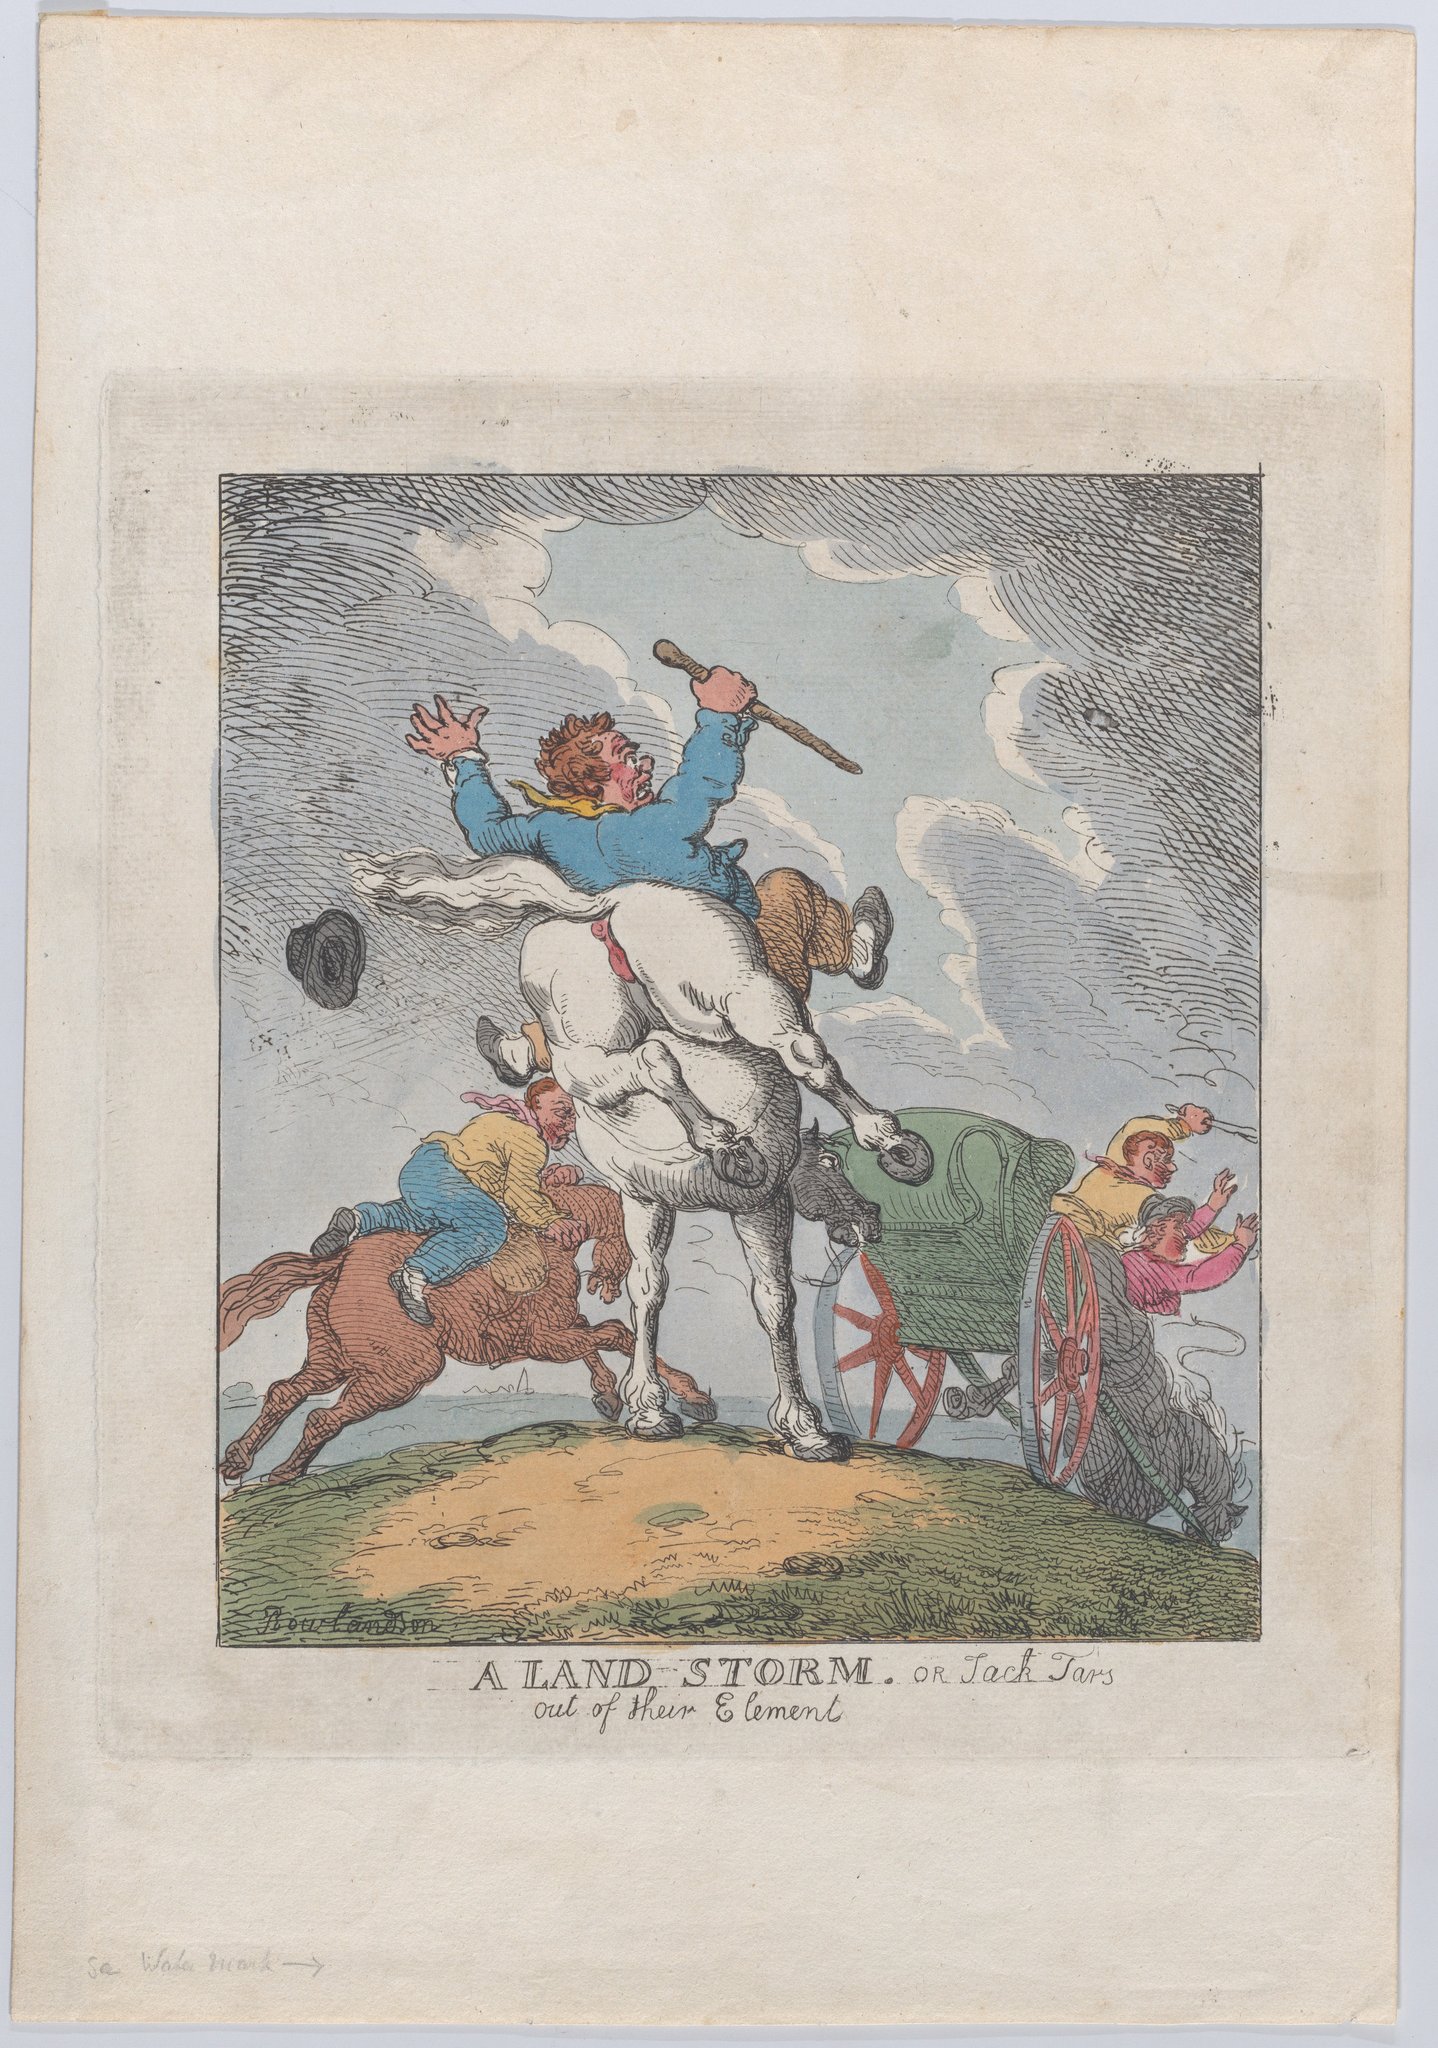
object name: print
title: A Land Storm, or Jack Tars Out of Their Element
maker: thomas rowlandson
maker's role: artist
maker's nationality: british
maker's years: 1757-1827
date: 1790-1815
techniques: etching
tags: satire,men,horses,carriages